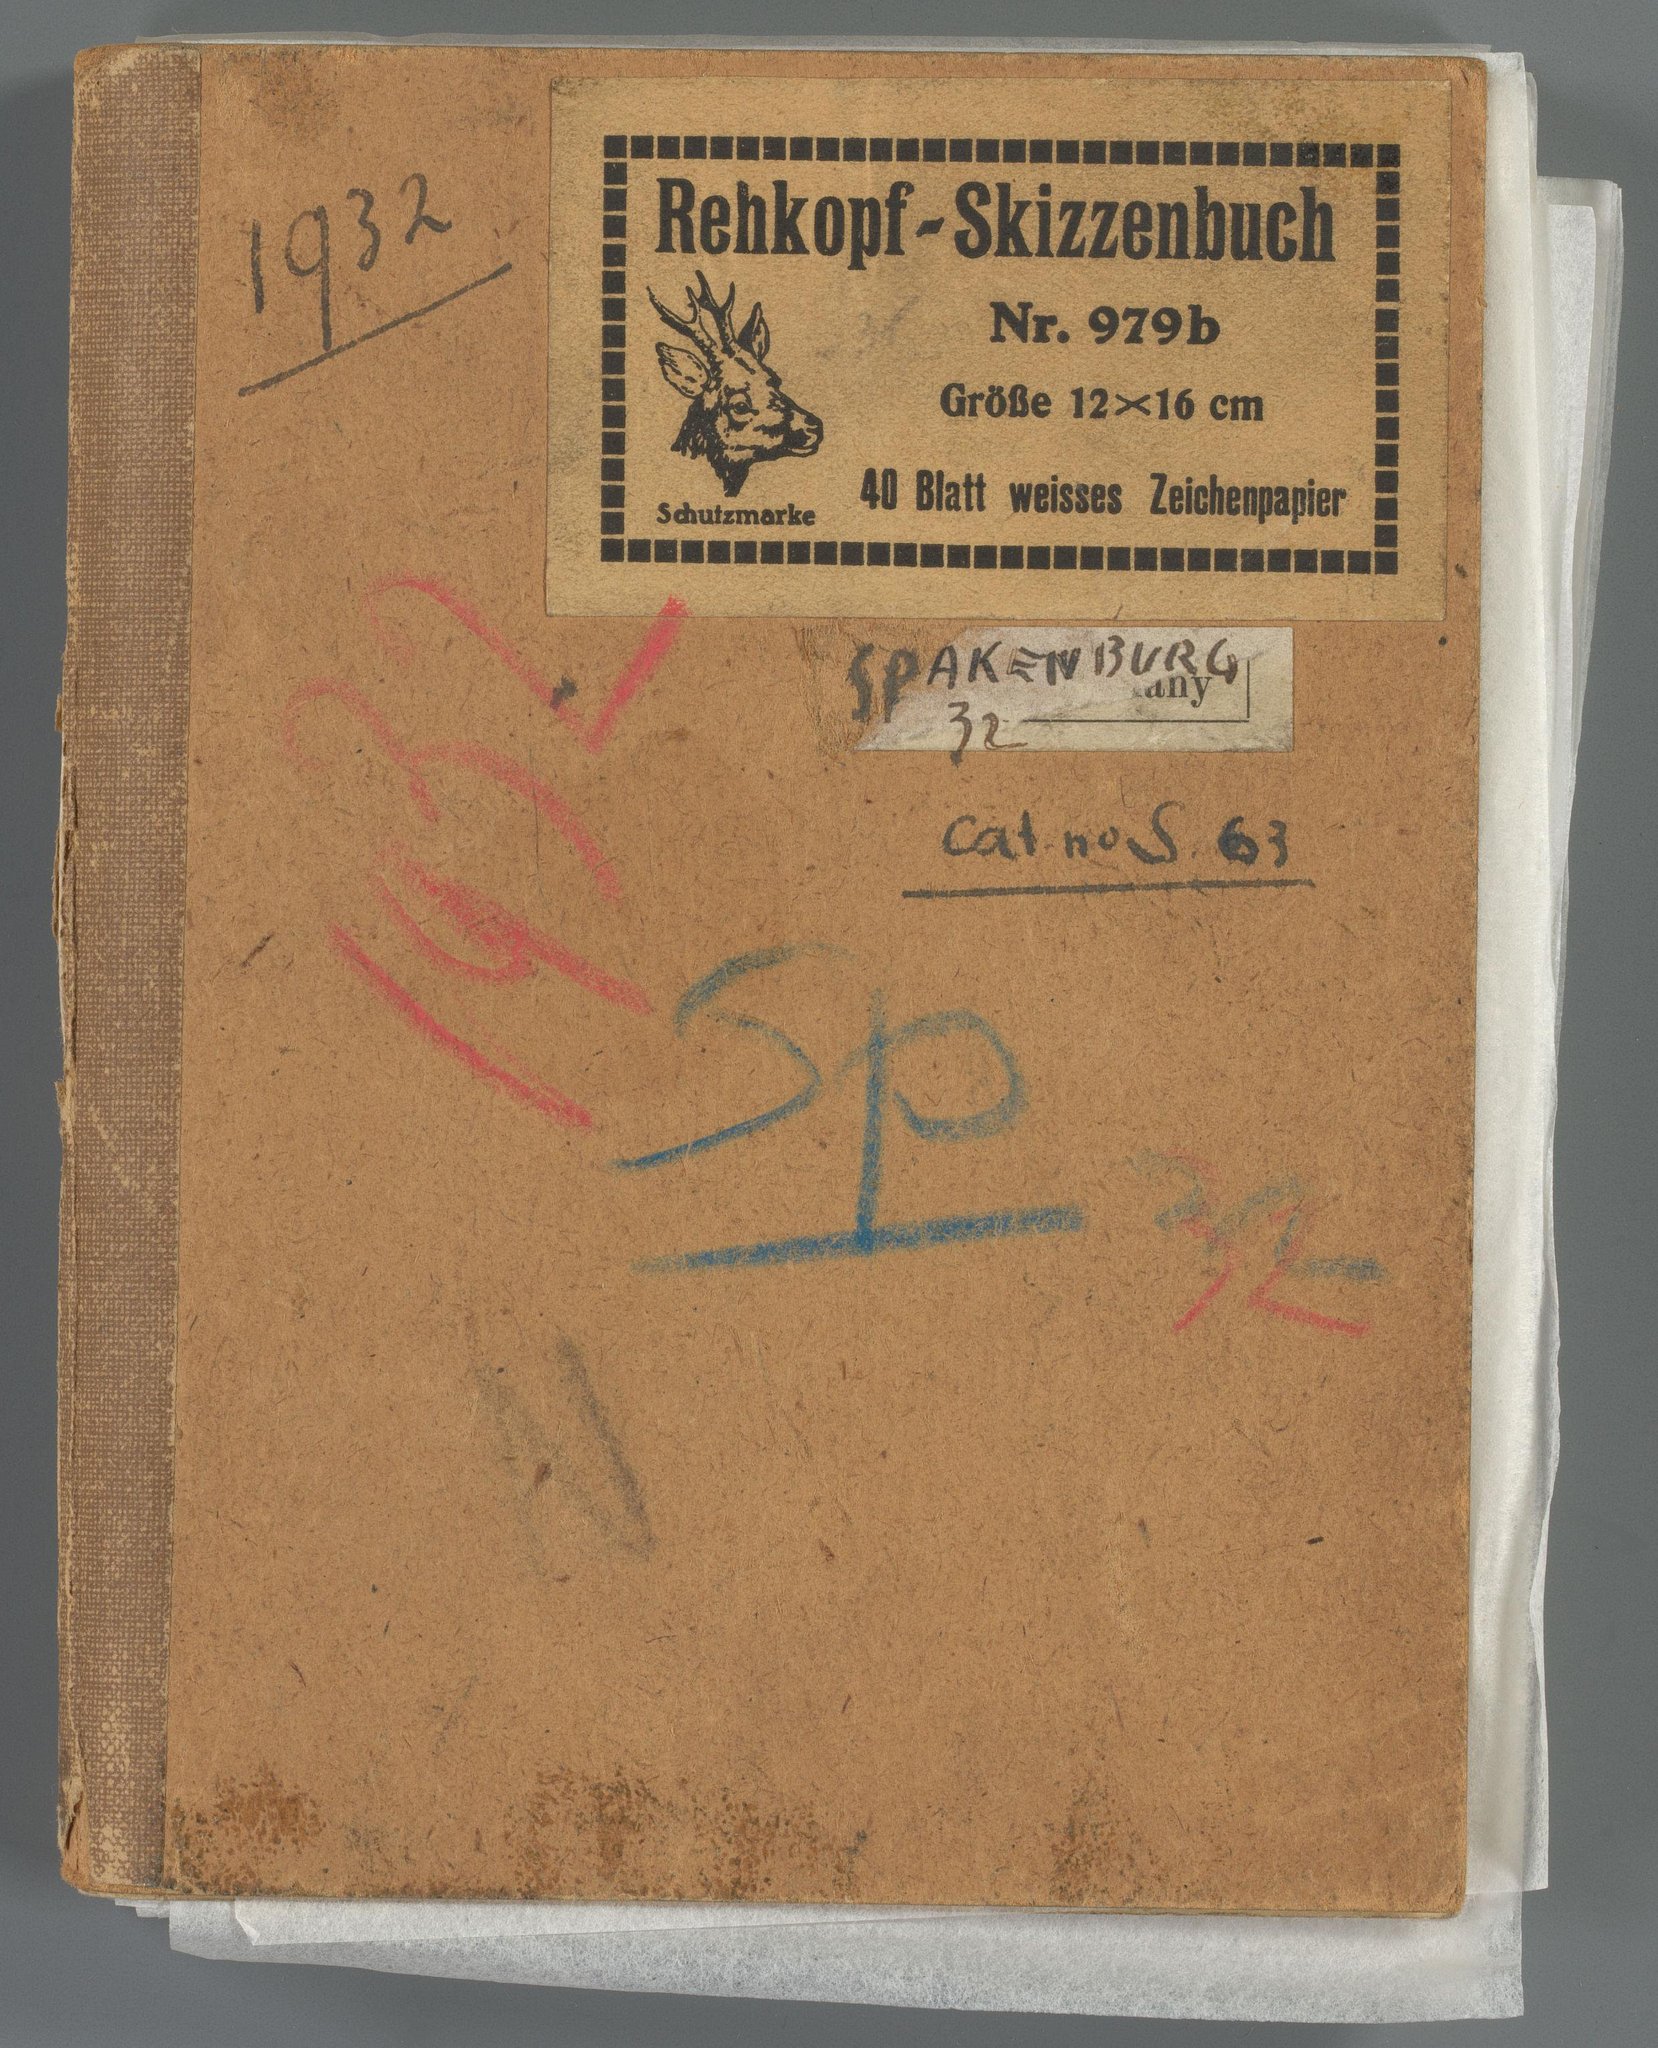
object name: sketchbook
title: Schetsboek Spakenburg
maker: leo gestel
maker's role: draughtsman, print maker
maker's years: 1881-1941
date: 1932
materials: chalk, charcoal, paper, pencil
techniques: drawing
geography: spakenburg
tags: harbour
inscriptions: inscription: ‘L Gestel Spakenburg Bl. 32 Haven’, title: ‘SPAKENBURG 32’, date: ‘1932’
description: Schetsboek van Spakenburg met schetsen van de bevolking, elf van de haven, drie van het dorp, drie van een landschap en twee koppen; zestien bladen eenzijdig, vierentwintig bladen tweezijdig.